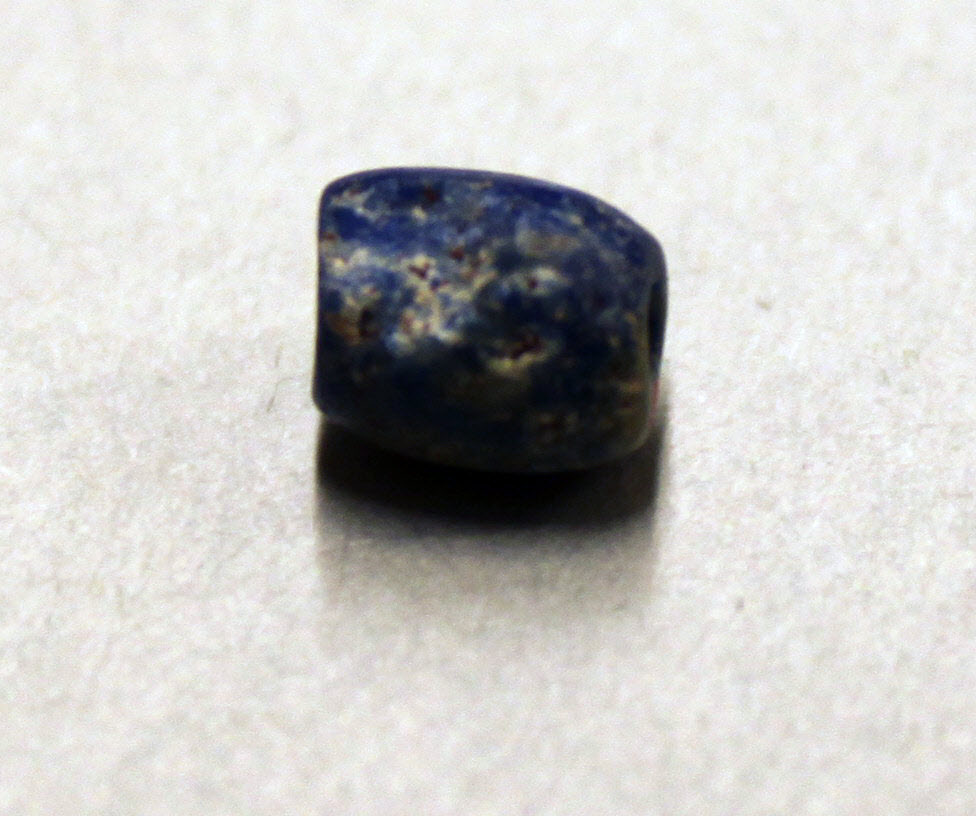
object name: bead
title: Beads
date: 801-1200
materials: lapis lazuli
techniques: cutting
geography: iran